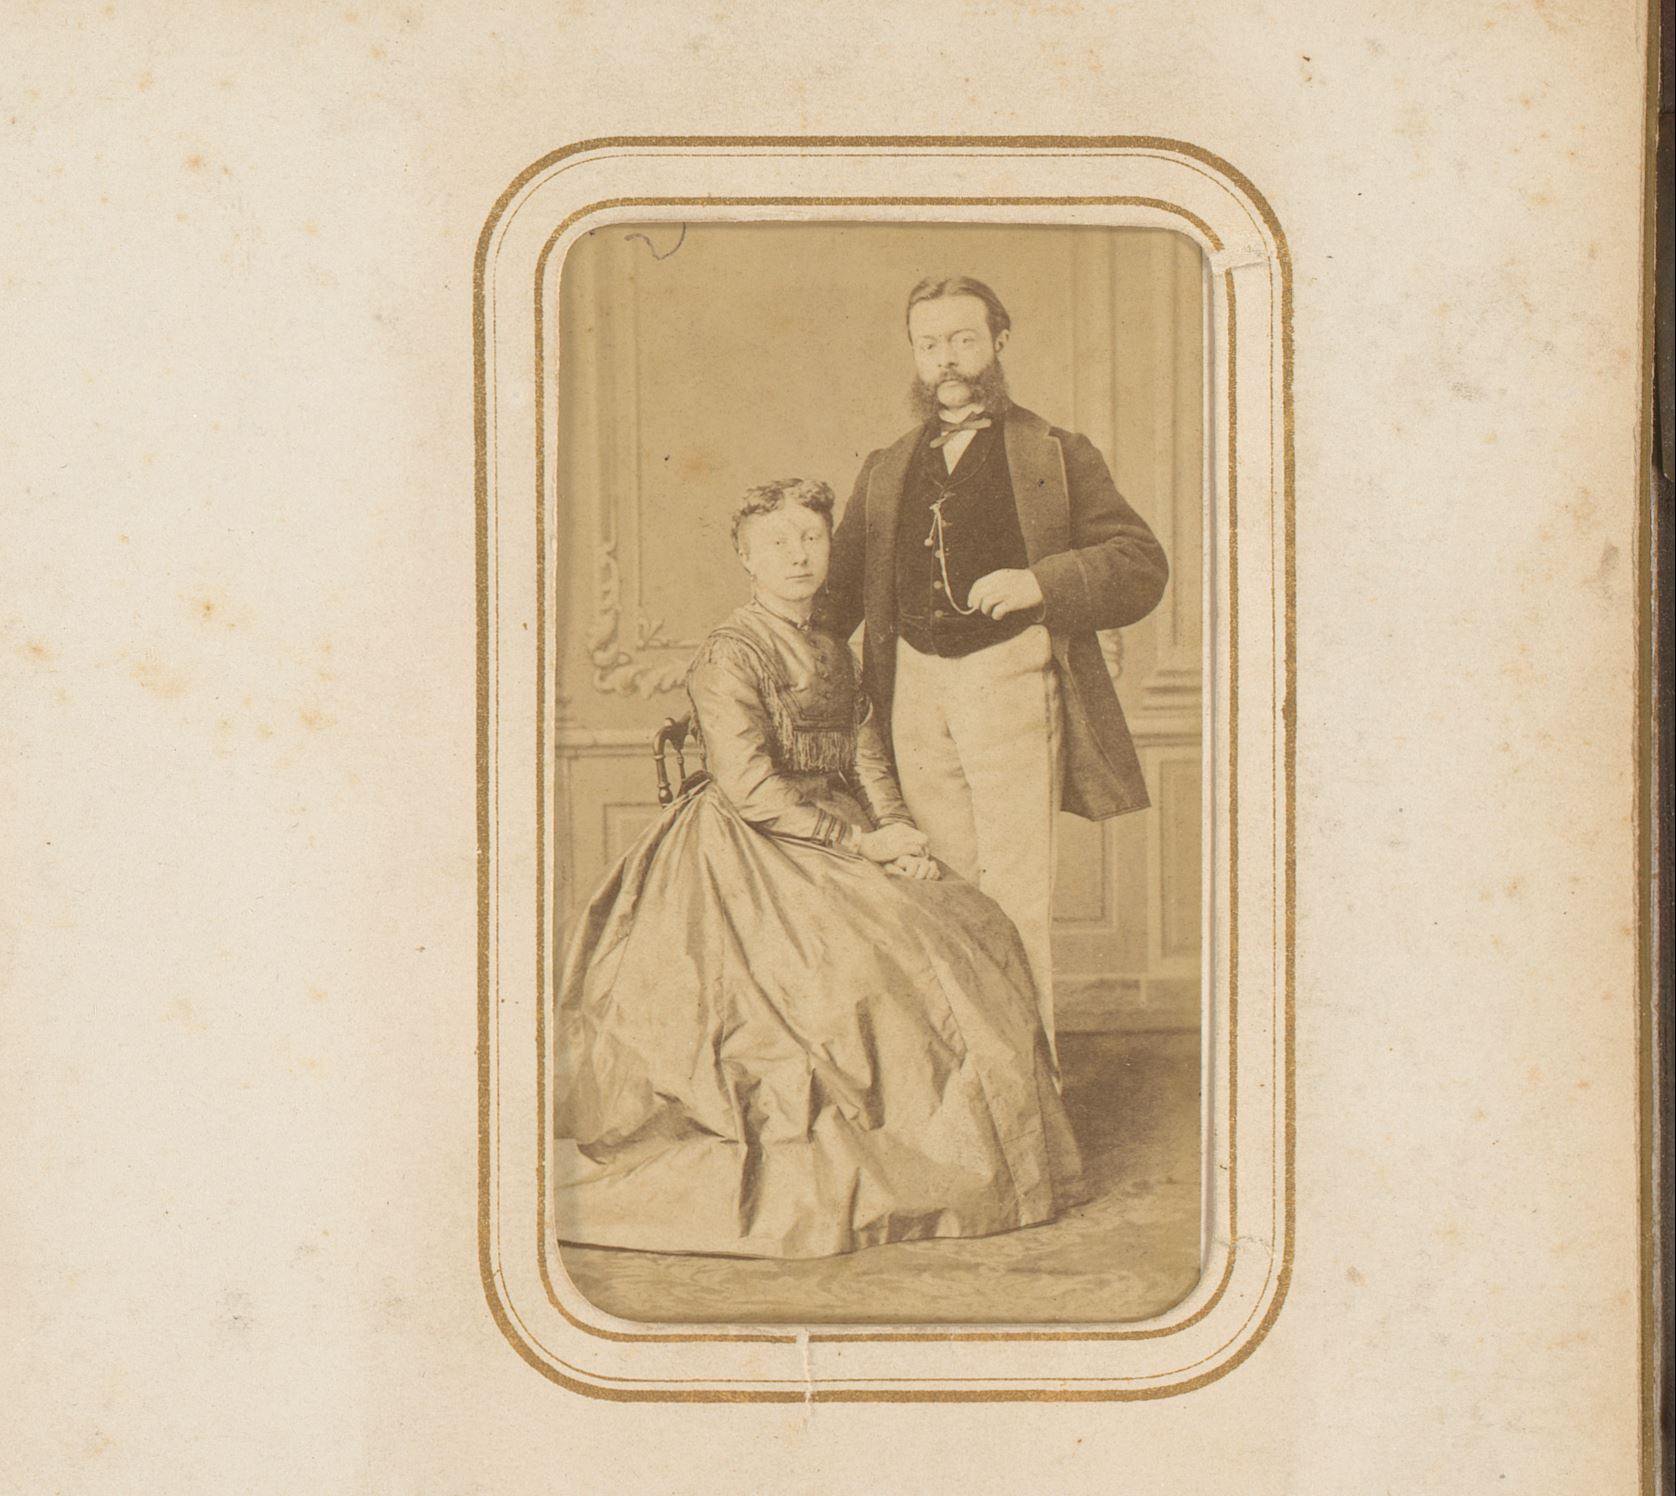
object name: album leaf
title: Portret van een echtpaar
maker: joseph maes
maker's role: fotograaf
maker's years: 1838-1908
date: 1880-1890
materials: cardboard, photographic support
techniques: albumen print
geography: antwerp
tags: couple of lovers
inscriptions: inscription: ‘Photographie/ Maes/ Place du Musée/ Anvers’